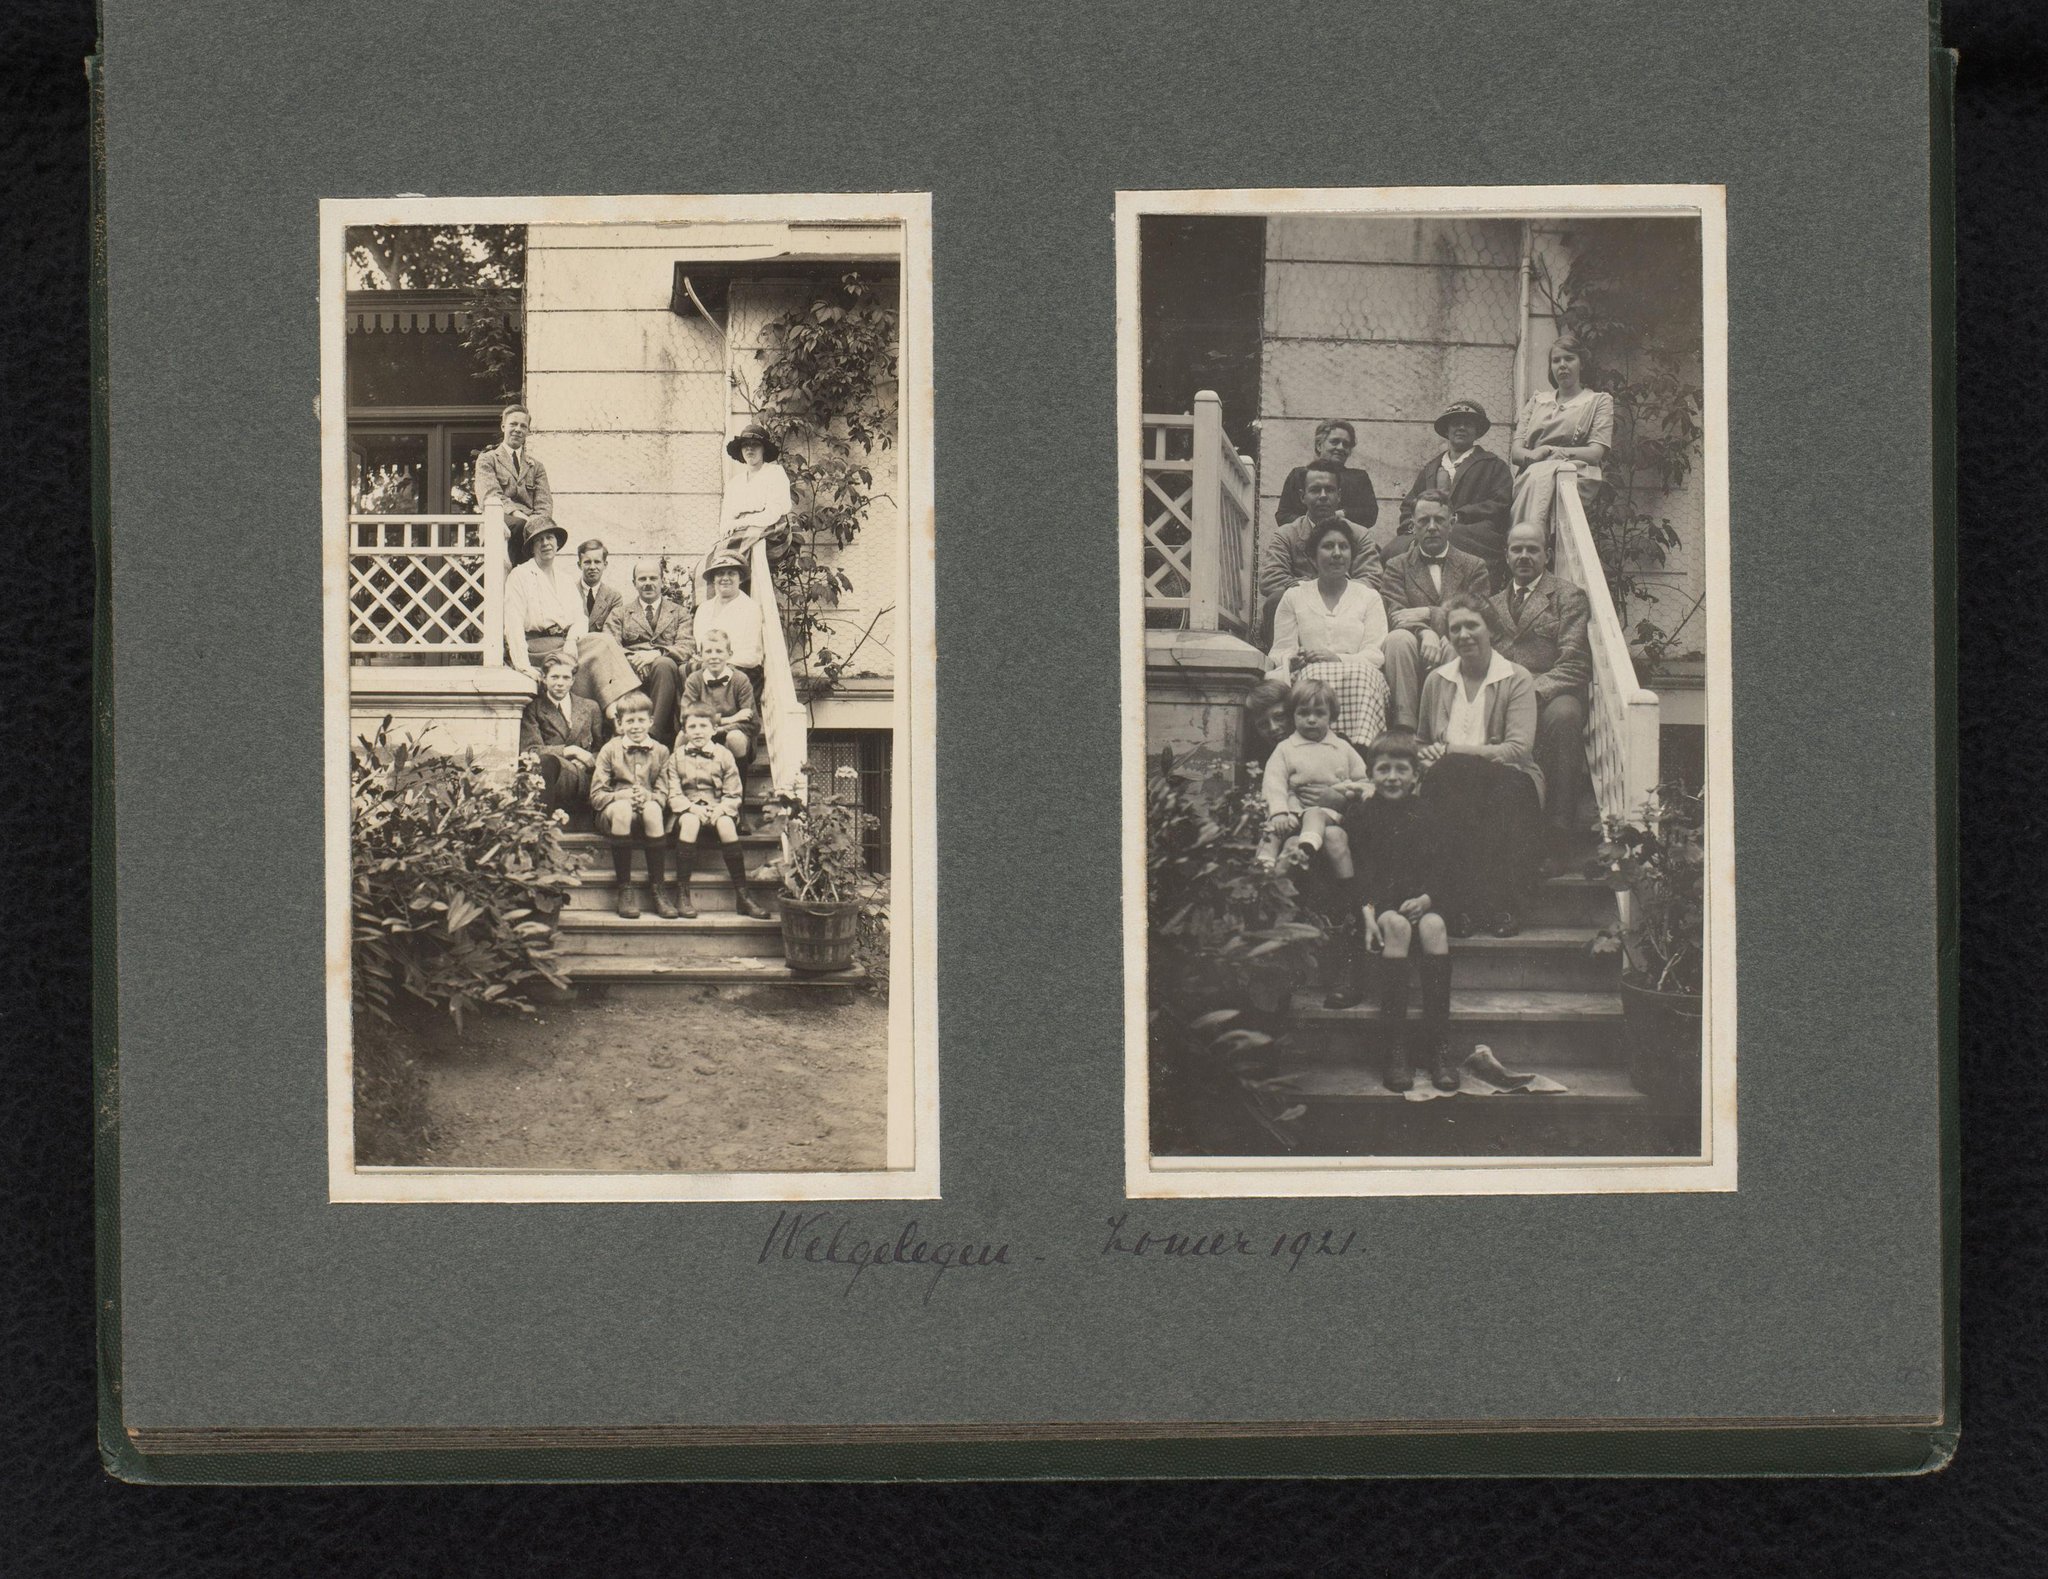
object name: photograph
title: Twee familieportretten van leden van familie Van den Berg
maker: hendrik herman van den berg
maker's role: amateurfotograaf, jurist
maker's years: 1875-1944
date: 1921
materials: paper, cardboard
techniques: gelatin silver print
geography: driebergen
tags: batavia, hendrik herman van den berg, the hague, caroline louise van den berg-van den berg, amsterdam, carel frederik van den berg (cay), frank willem van den berg (1912-1998), historical persons, family life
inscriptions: caption: ‘Welgelegen Zomer 1921’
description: Deze foto's maken deel uit van een album.